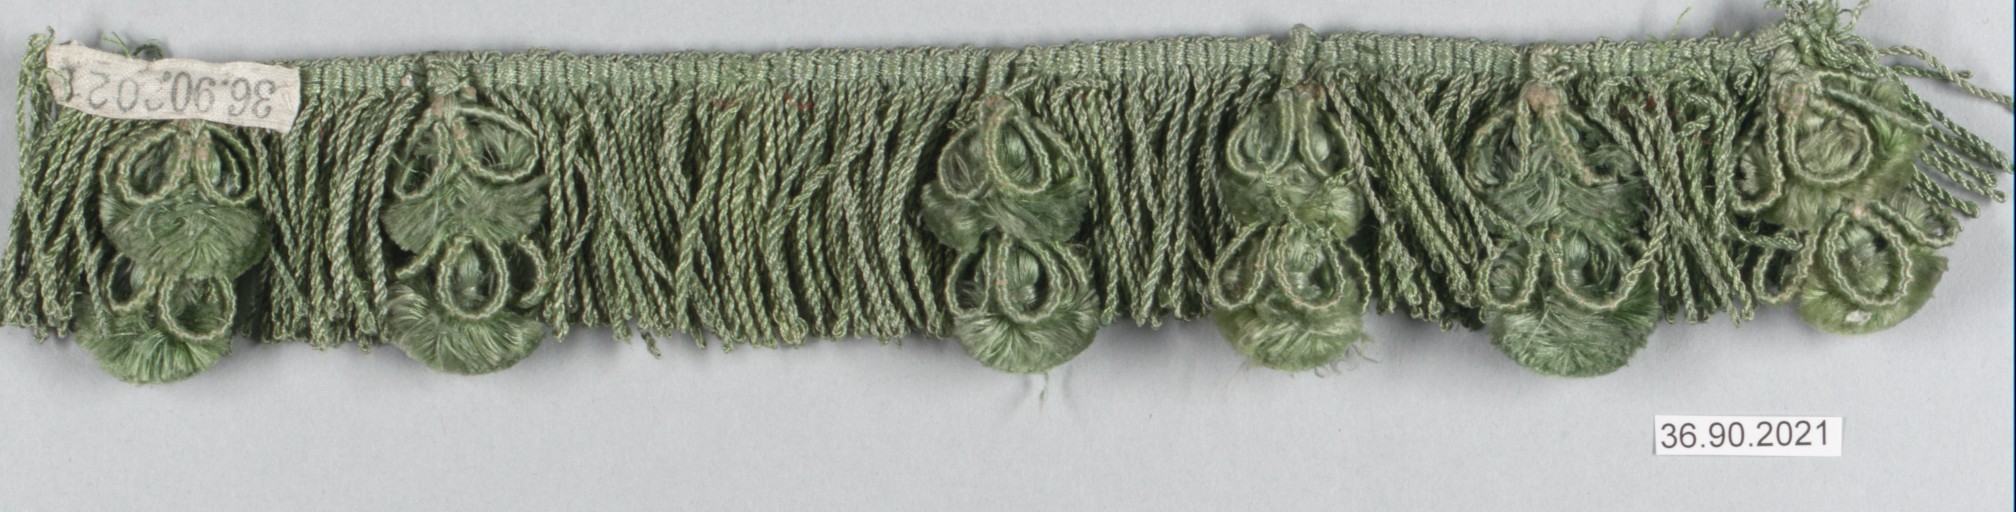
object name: fringe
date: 1801-1833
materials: silk